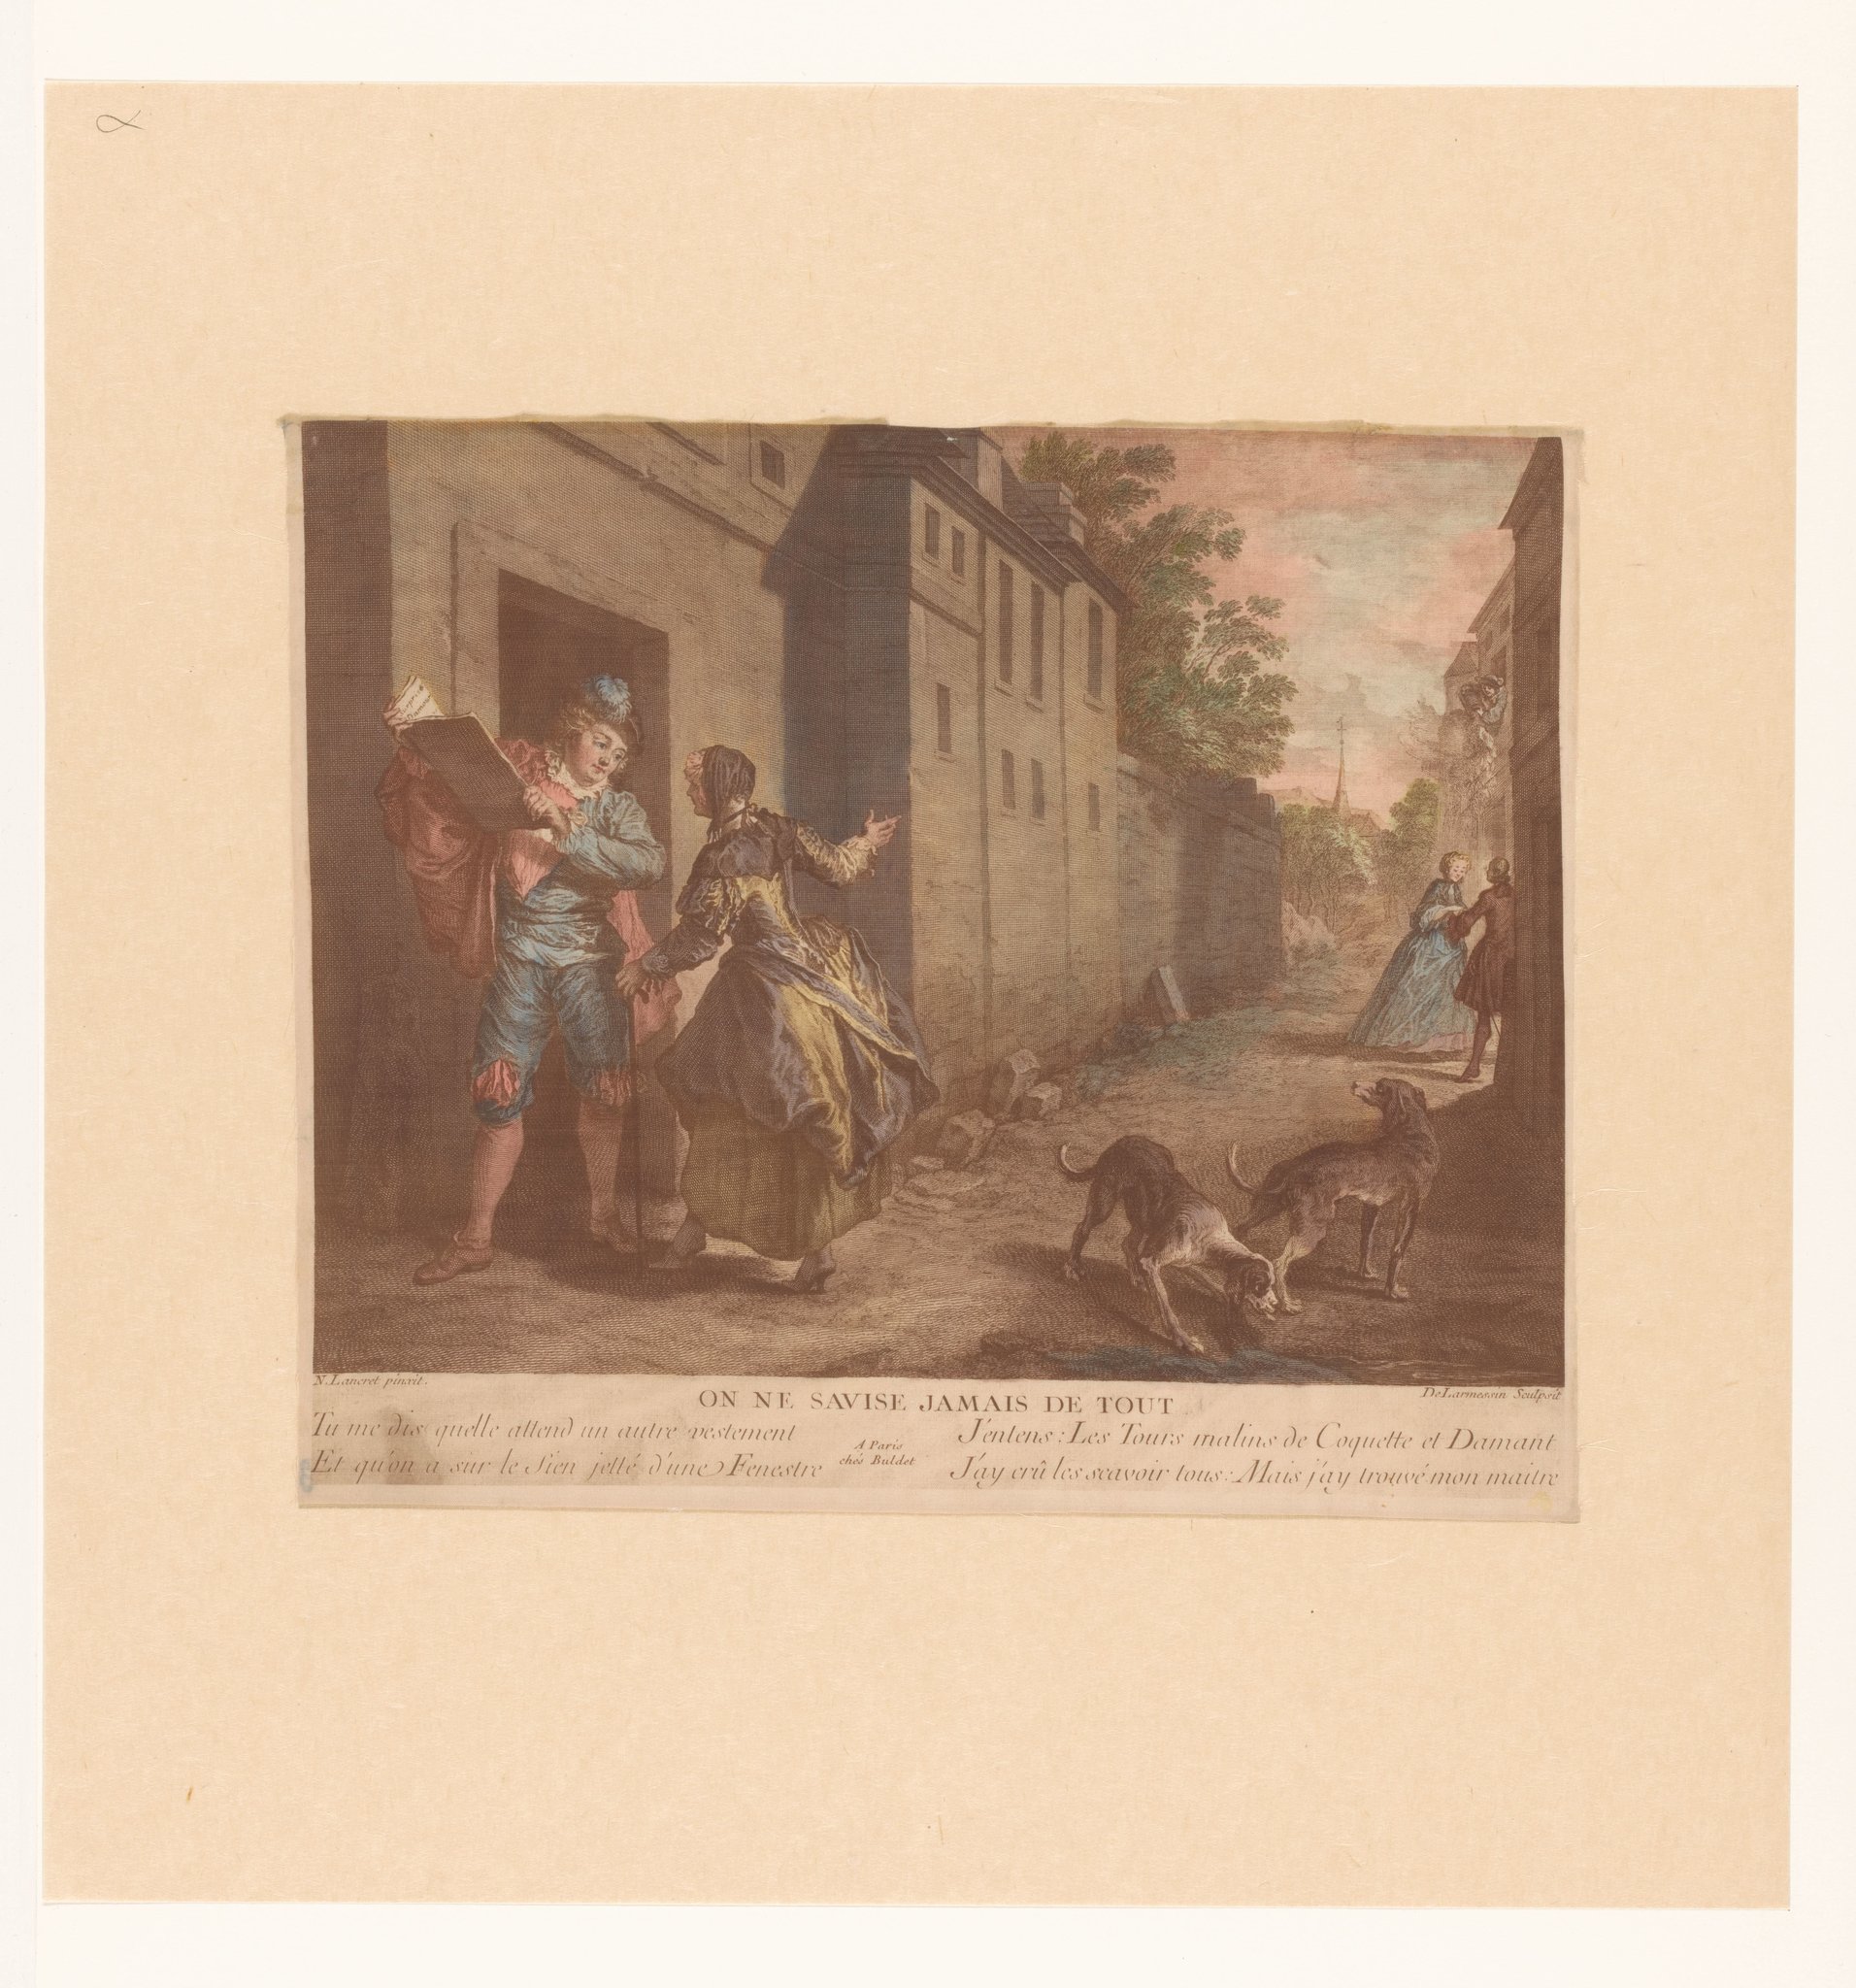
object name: print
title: Straatgezicht met man met boek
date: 1736-1738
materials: silk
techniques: engraving, etching, hand coloring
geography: paris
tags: book, lane, alley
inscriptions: collector's mark: Lugt 2228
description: Elegant geklede man met een opengeslagen boek wordt door een oude vrouw gewaarschuwd. Ze gebaart naar een figuur verderop die zijn afvalemmer uit het raam op straat leegt.